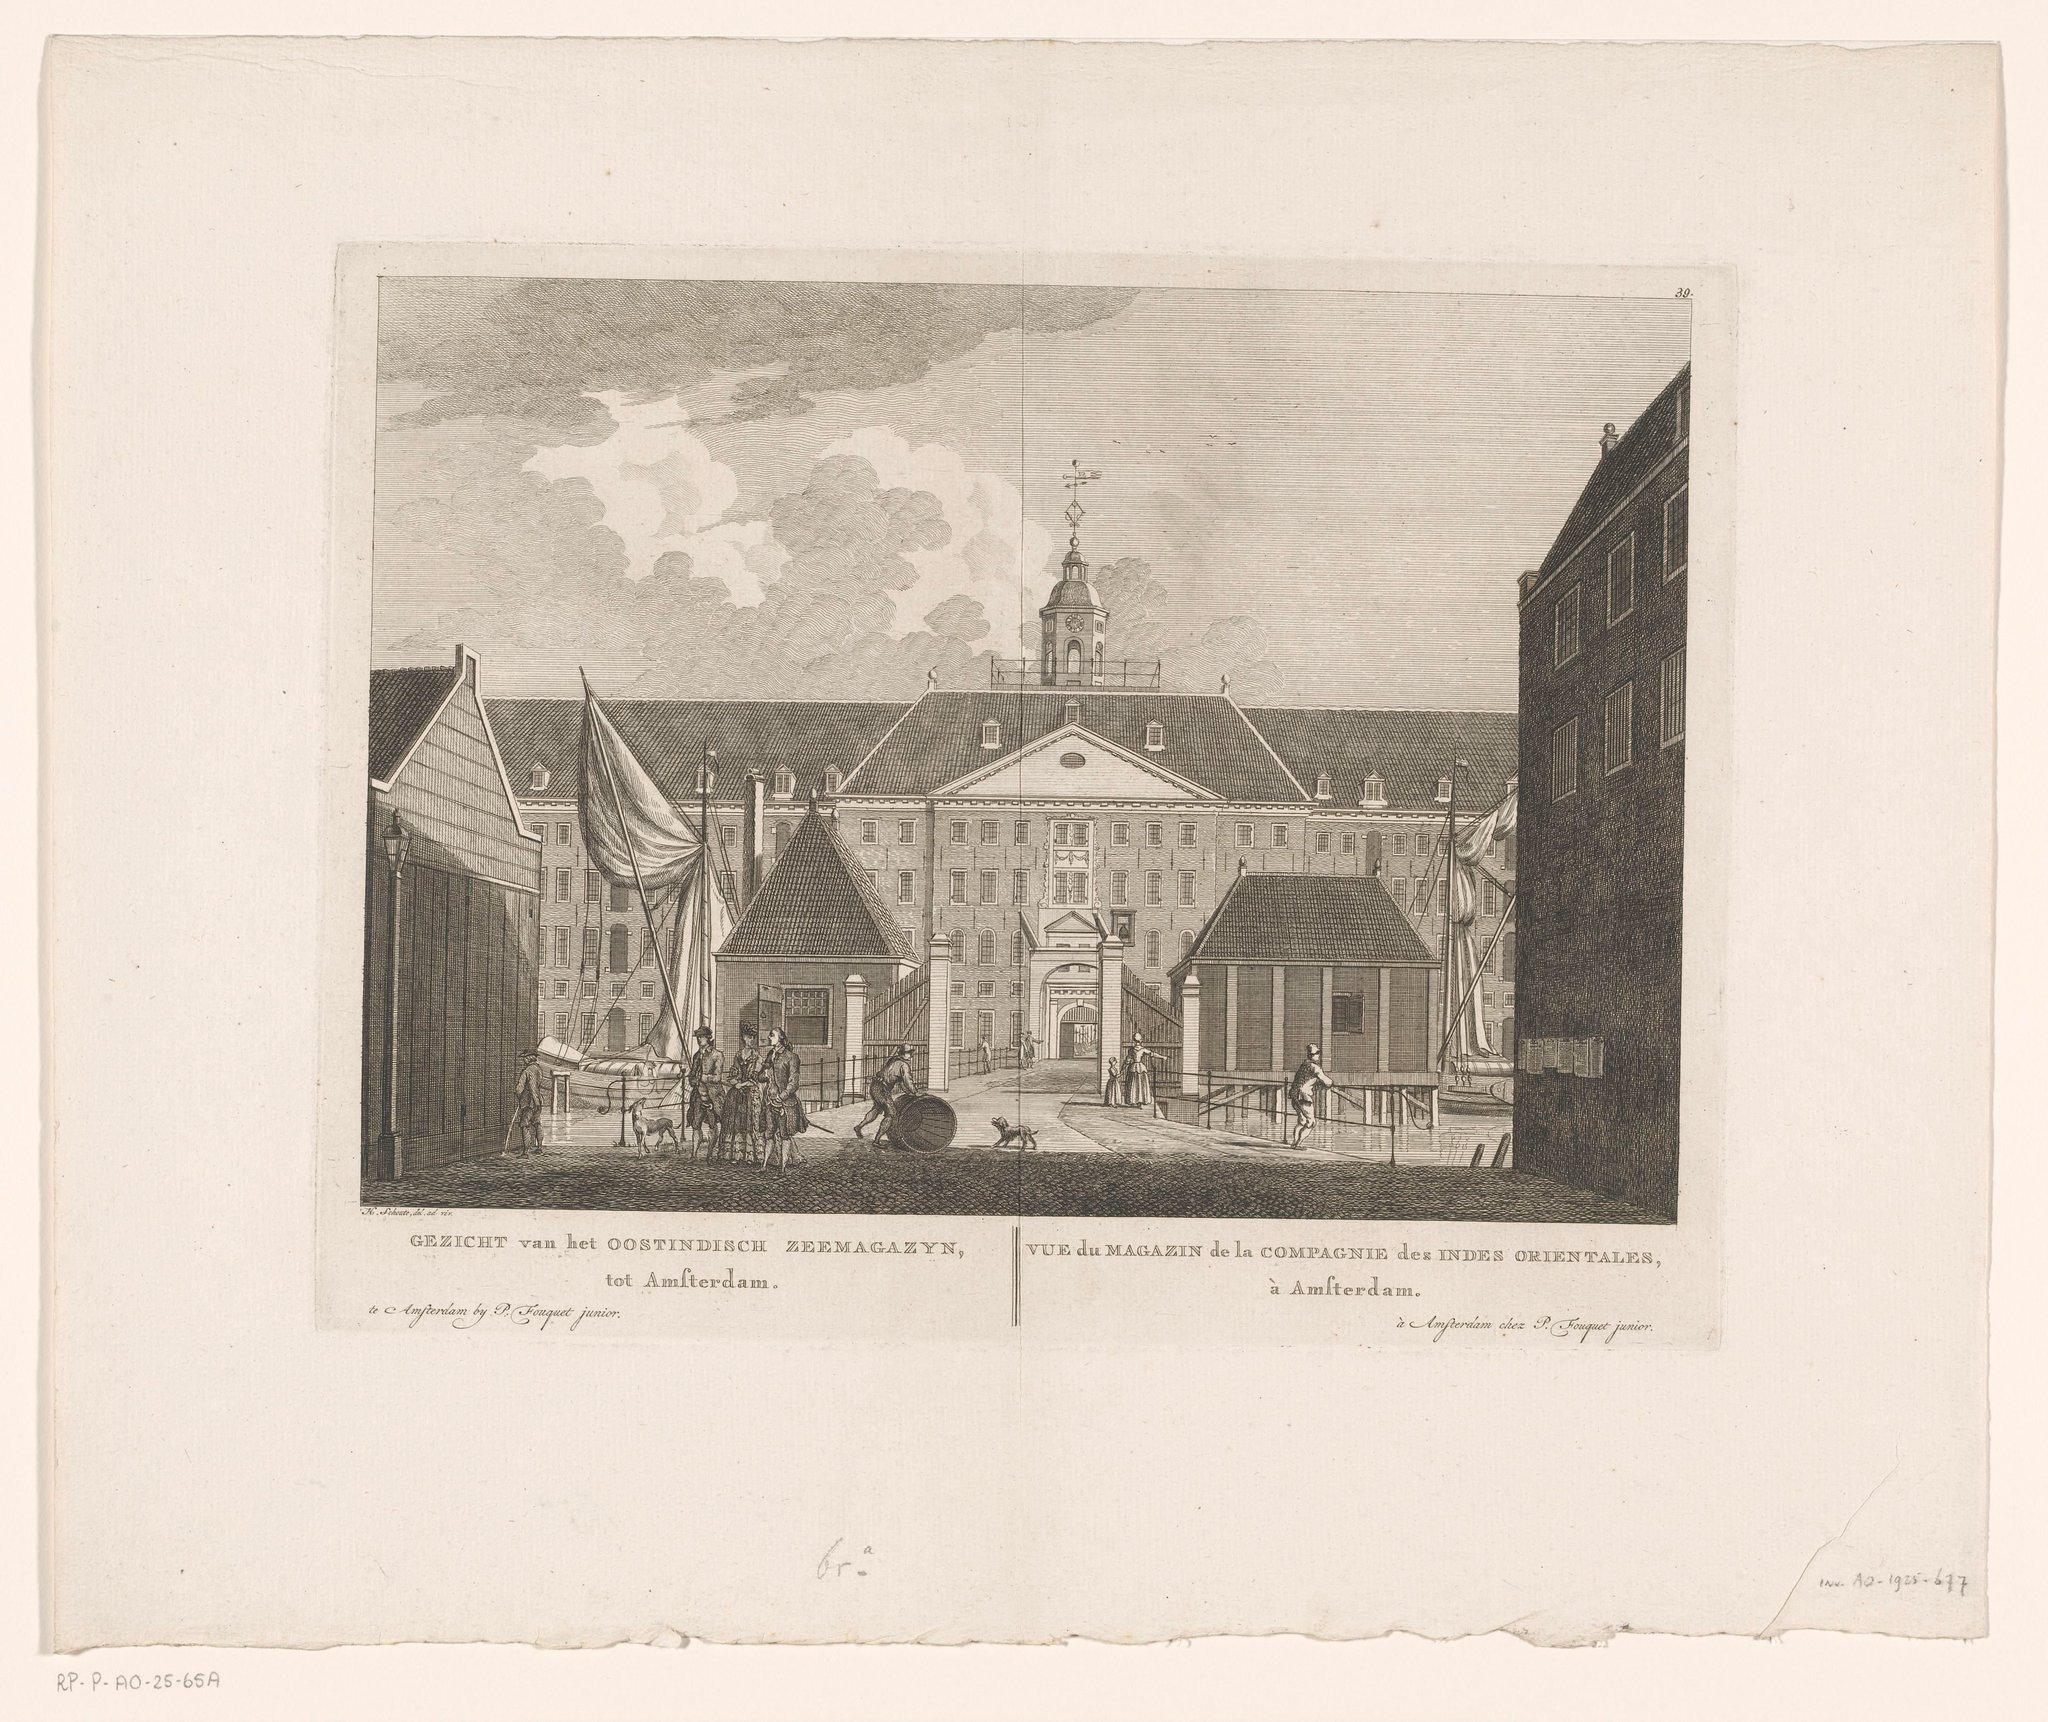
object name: print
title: Gezicht van het Oost-Indisch Zeemagazijn op Oostenburg te Amsterdam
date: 1770-1783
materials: paper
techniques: engraving, etching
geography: amsterdam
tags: large-scale structure for storage, e.g.: warehouse, depot, silo, trade-company, shipyard, shipdock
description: Deze prent is ook gebruikt in de zogenaamde Atlas van Fouquet.* Pierre Fouquet gaf vanaf 1760 stadsgezichten van Amsterdam - naar tekeningen van verschillende kunstenaars, gemaakt door verschillende prentmakers - uit. Deze prenten werden aanvankelijk los of in series verkocht. Zoals toen gebruikelijk kon de koper de prenten zelf laten inbinden. Hiertoe gaf Fouquet tussen 1778 en 1783 een titelblad, plattegrond en inhoudsopgave van de tot dusver 100 uitgegeven prenten uit (1). Gezien de inhoud afhankelijk was van wat de koper had verzameld verschilt de inhoud van de verschillende bewaarde Fouquetatlassen onder deze titel sterk. Ook zijn er exemplaren bekend waar tevens andere prenten aan zijn toegevoegd. Omdat er behoefte bleek aan uitleg bij de platen werd in 1783 een nieuwe versie van de atlas uitgegeven, aangevuld met tekst en twee prenten. De aangegeven volgorde veranderde maar de platen van de al eerder uitgegeven prenten bleven ongewijzigd. Deze uitgave werd in opdracht van Fouquet gedrukt bij Daniël Jean Changuion en Petrus den Hengst (2). Een tiental platen werd bijgewerkt en verscheen, met nieuw impressum, in het vervolg van Wagenaars geschiedenis van Amsterdam, uitgeven door Petrus Conradi en Folkert van der Plaats (3). Een aantal jaar na het overlijden van Fouquet kwam Evert Maaskamp met een nieuwe uitgave van de atlas, met verbeterde tekst en toevoeging van twee prenten. Op alle platen verwijderde hij het oude en liet hij zijn eigen impressum zetten (4). De huidige staat van de prent komt voor in exemplaren van de onder (1) en (2) genoemde werken. * Onder de Atlas van Fouquet of Fouquetatlas verstaan we de hieronder vermelde publicaties (1), (2) en (4). (1). Afbeeldingen van de wyd-vermaarde koopstad Amsterdam benevens des zelvs voornaamste gebouwen en gezigten alle naar het leeven getekend / Receuil des edifices les plus considerables et des plus belles vues, de la fameuse ville d'Amsterdam, dessinées d'après nature. Amsterdam: Pierre Fouquet, 1778-1783. (2). Nieuwe atlas, van de voornaamste gebouwen en gezigten der stad Amsterdam, met derzelver beknopte beschryvingen. 2 delen. Amsterdam: Daniël Jean Changuion en Petrus den Hengst [in opdracht van Pierre Fouquet], 1783. (3). Stijl, Simon. Amsterdam, in zyne geschiedenissen, voorregten, koophandel, gebouwen, kerkenstaat, schoolen, schutterye, gilden en regeeringe, beschreeven. Om te dienen ten vervolge op het werk van Jan Wagenaar (…). 10 delen. Amsterdam en Harlingen: Petrus Conradi en Folkert van der Plaats, 1788-1801. (4). Nieuwe atlas, van de voornaamste gebouwen en gezigten der stad Amsterdam. Met derzelver beknopte beschryvingen. Amsterdam: Evert Maaskamp, 1805. * Het aantal vermelde staten is gebaseerd op het aantal gevonden staten. Mogelijk zijn er meer staten van deze prent.